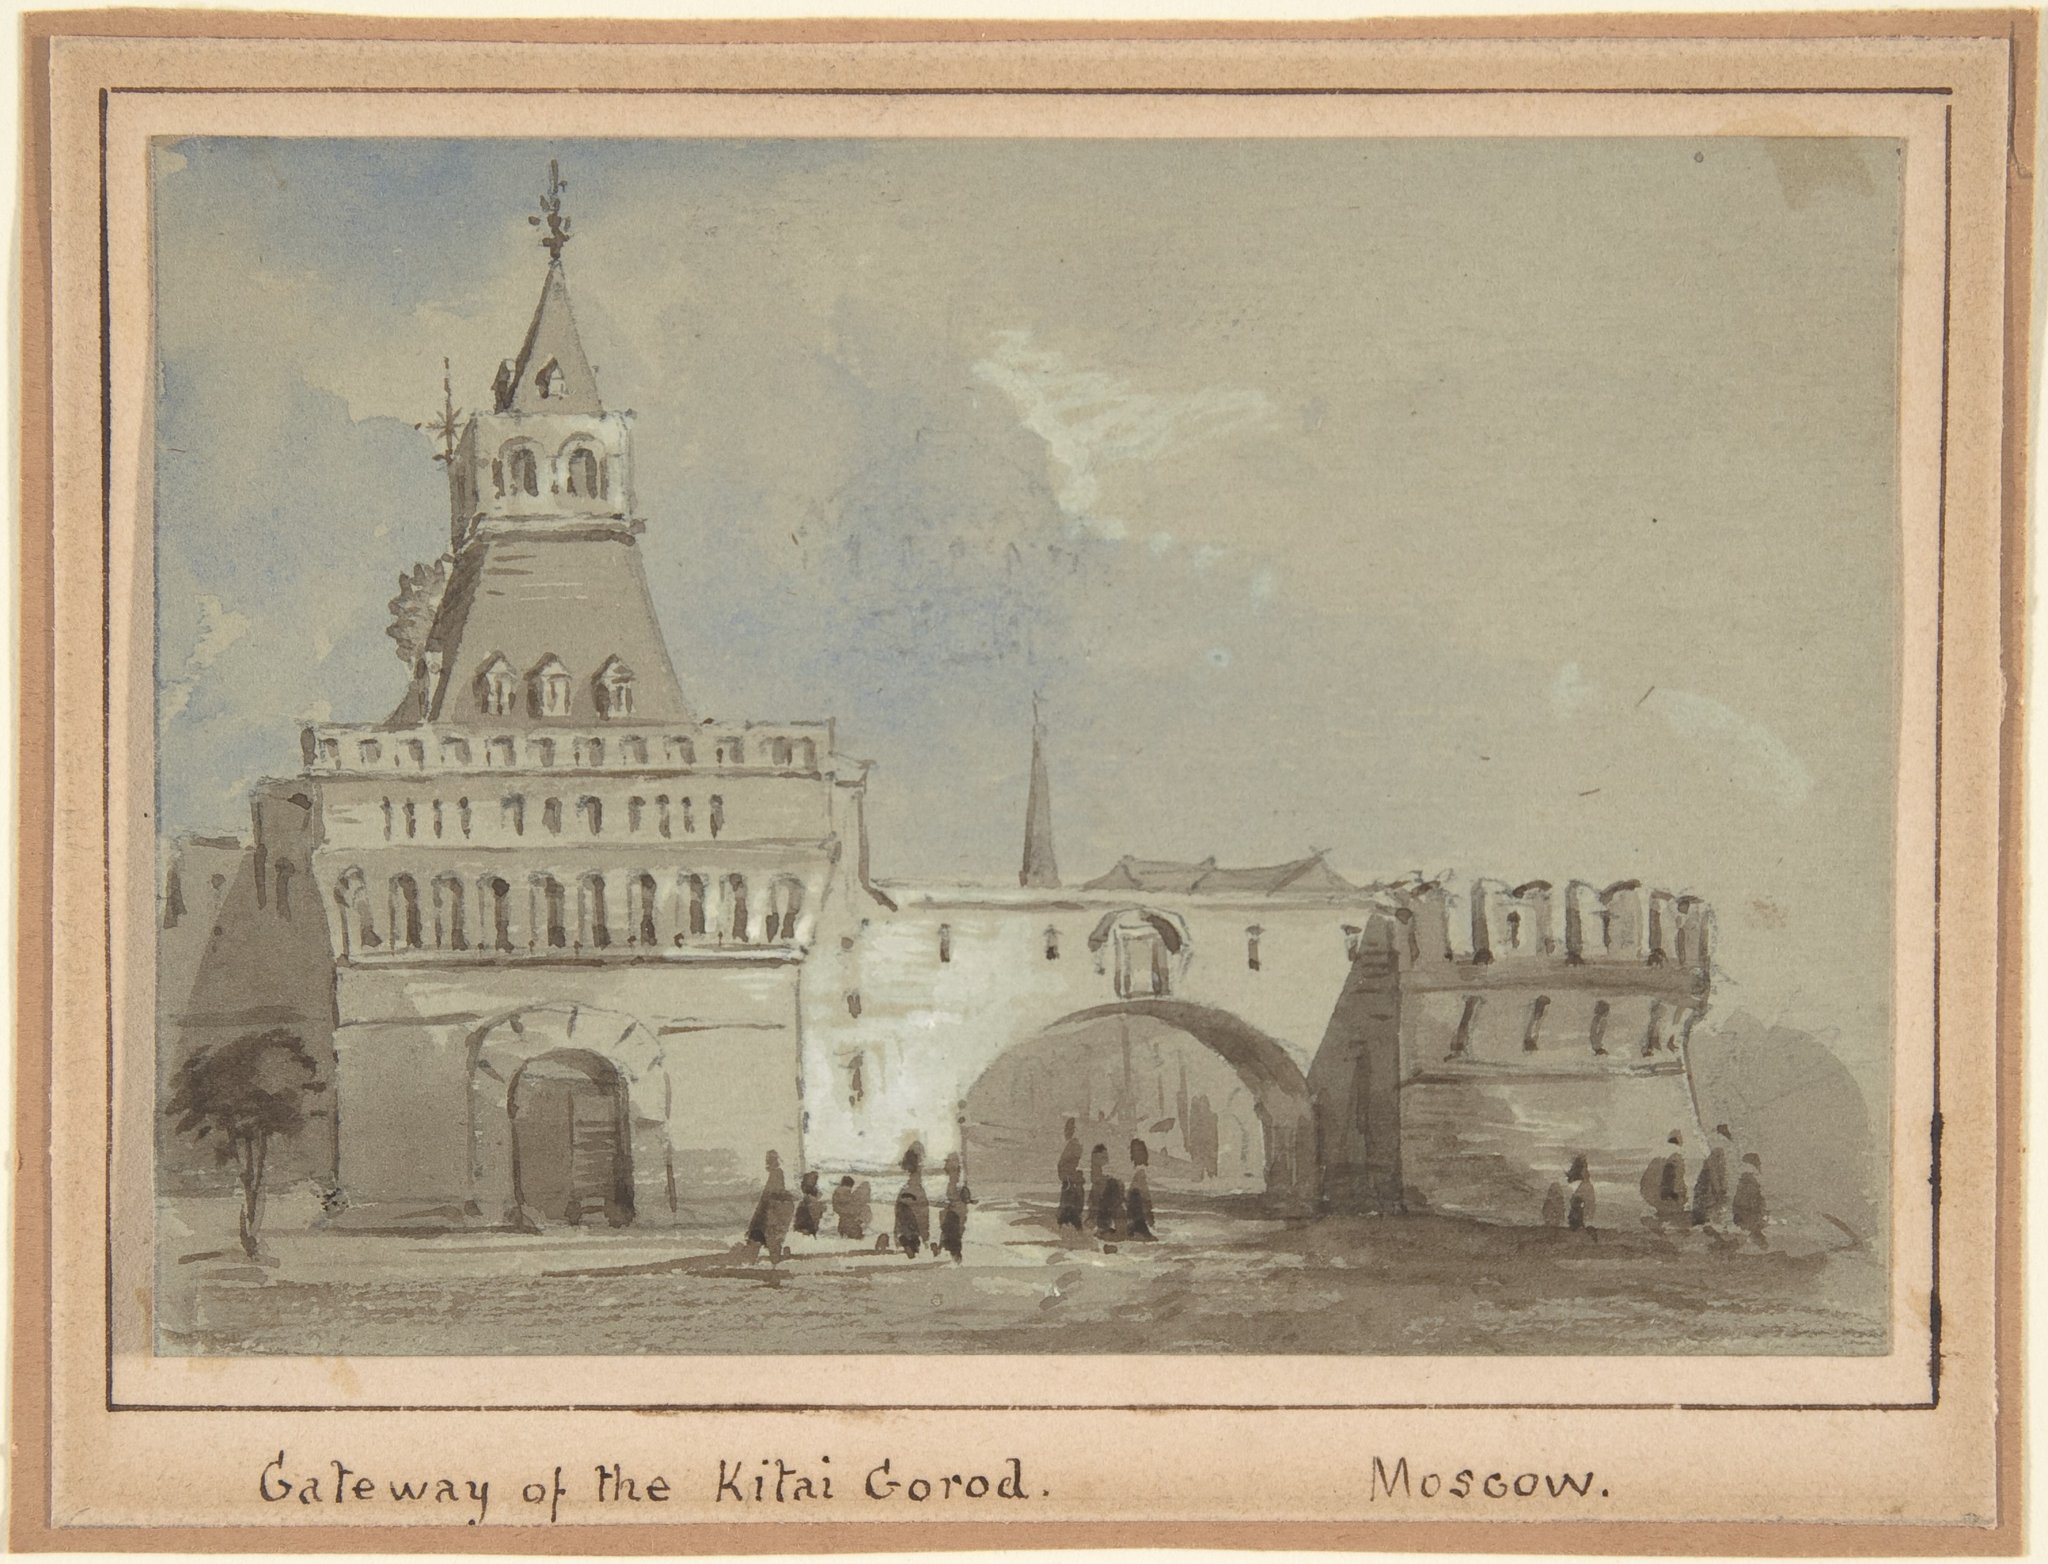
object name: drawing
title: Gateway of the Kitai Gorod, Moscow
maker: anonymous, russian, 19th century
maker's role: artist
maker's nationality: russian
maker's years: 1800-1900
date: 1801-1900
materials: watercolor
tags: arches,buildings